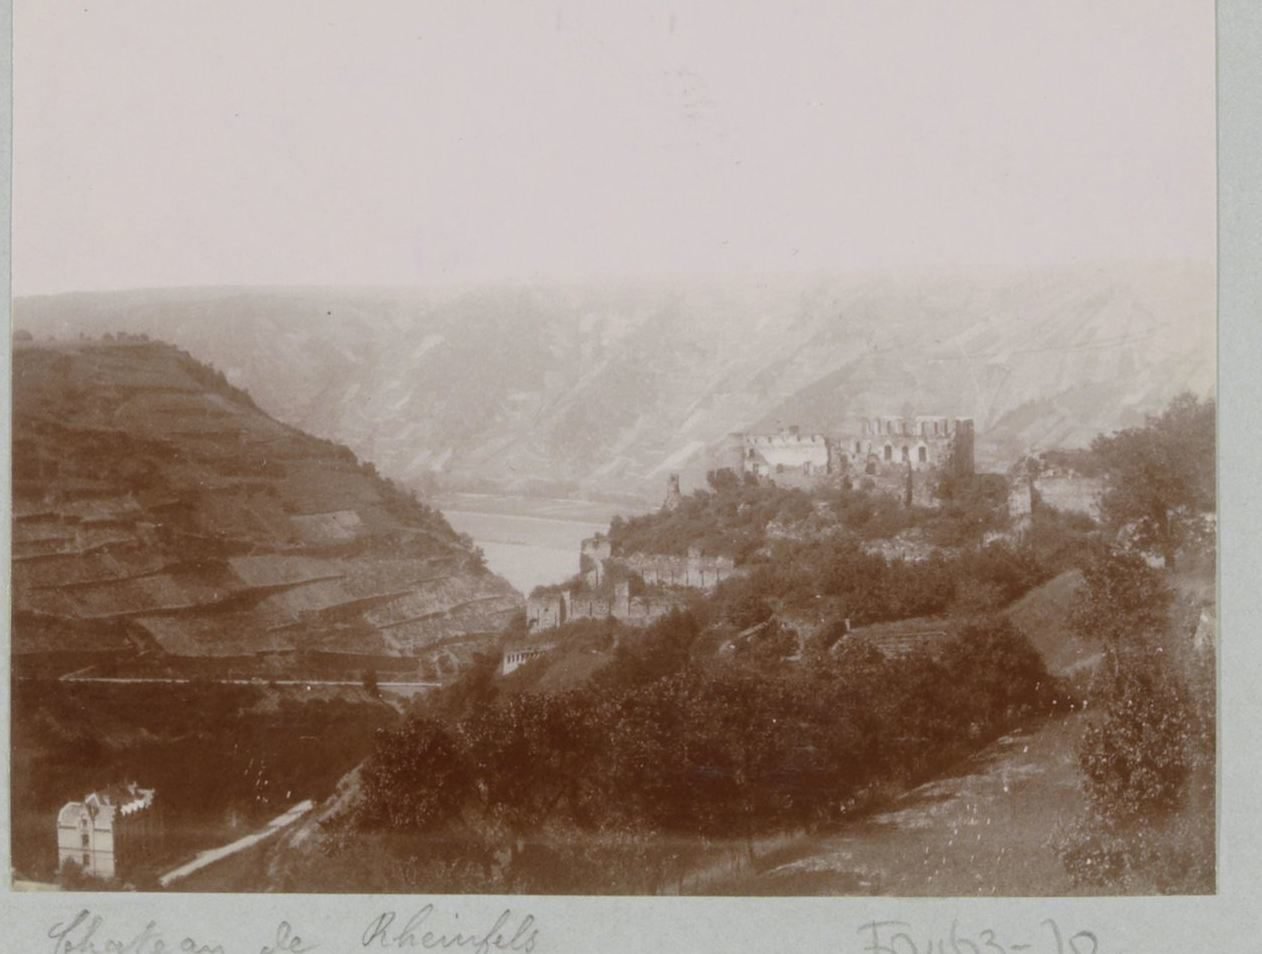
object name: photograph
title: Gezicht op de Rijnvallei met rechts Burcht Rheinfels bij Sankt Goar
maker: delizy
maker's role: manufacturer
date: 1900-1906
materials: paper, photographic support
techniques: gelatin silver print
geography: germany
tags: dale, valley, landscape with ruins, ruin of a dwelling, house, castle, etc.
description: Onderdeel van Fotoalbum van een Franse amateurfotograaf met opnames van uitstapjes in Frankrijk, Spanje, België, Luxemburg en Nederland, de eerste automobielen en autoraces.